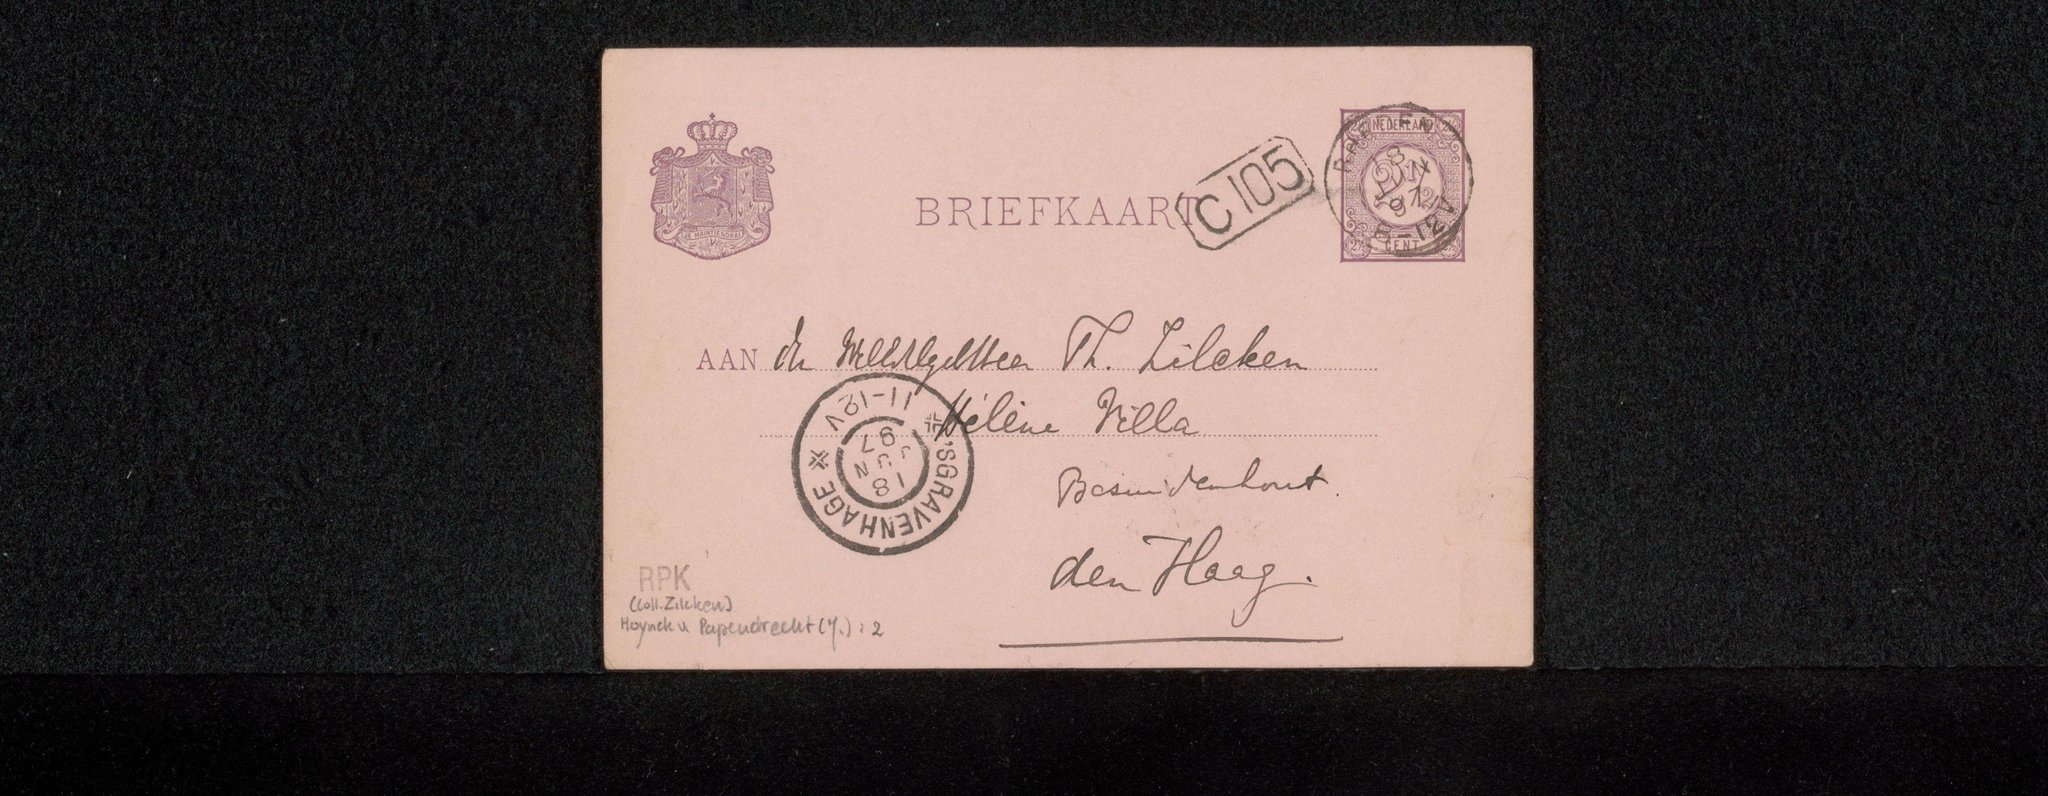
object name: postcard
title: Briefkaart aan Philip Zilcken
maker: jan hoynck van papendrecht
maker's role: draughtsman, painter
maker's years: 1858-1933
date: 1897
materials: cardboard, ink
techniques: pen, writing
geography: rheden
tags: the hague, painter, draughtsman, philip zilcken, drawing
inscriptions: collector's mark: ‘RPK’